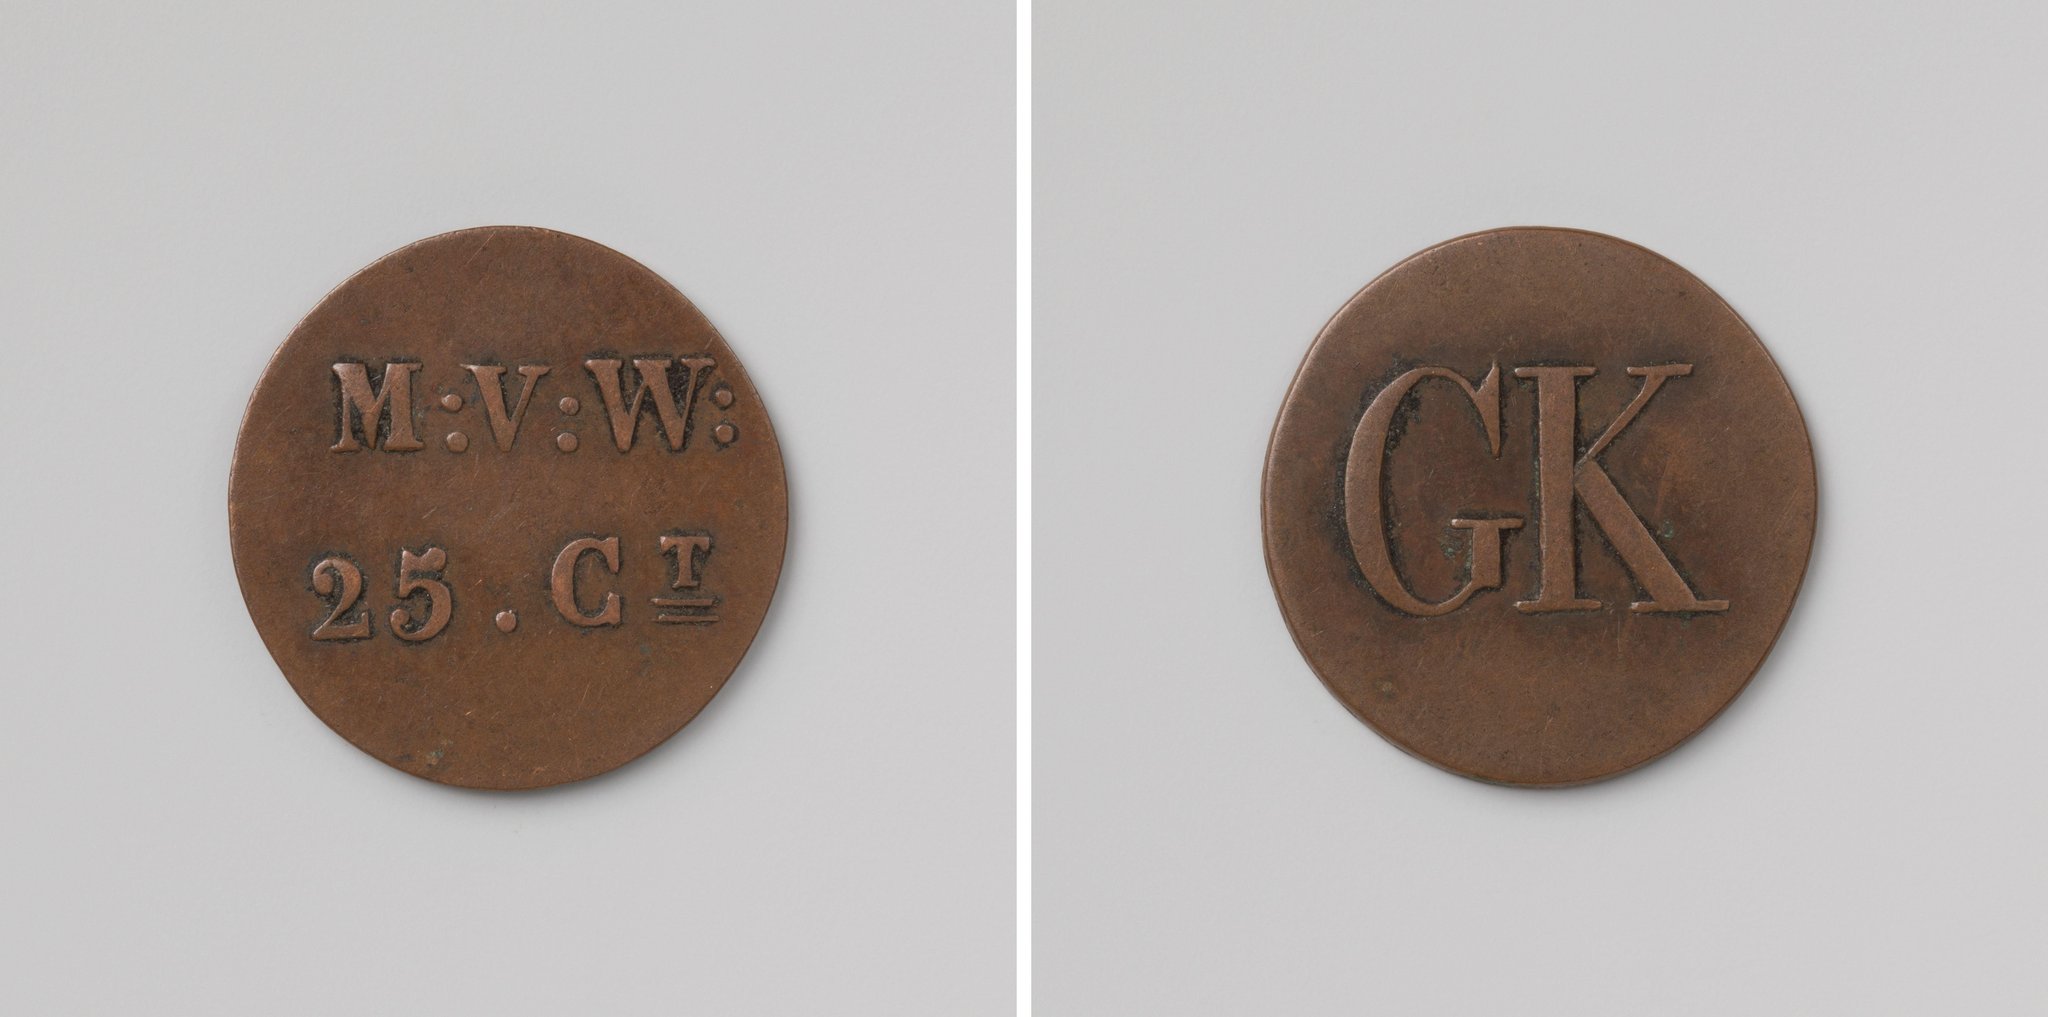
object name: monetary token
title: Huismunt geslagen op last van de Maatschappij van Weldadigheid ter waarde van 25 cent, ten behoeve van de Gewone Koloniën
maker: Anonymous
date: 1818-1859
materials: copper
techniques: striking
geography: netherlands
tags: maatschappij van weldadigheid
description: Voorzijde: opschrift boven waardeaanduiding. Keerzijde: opschrift G en K